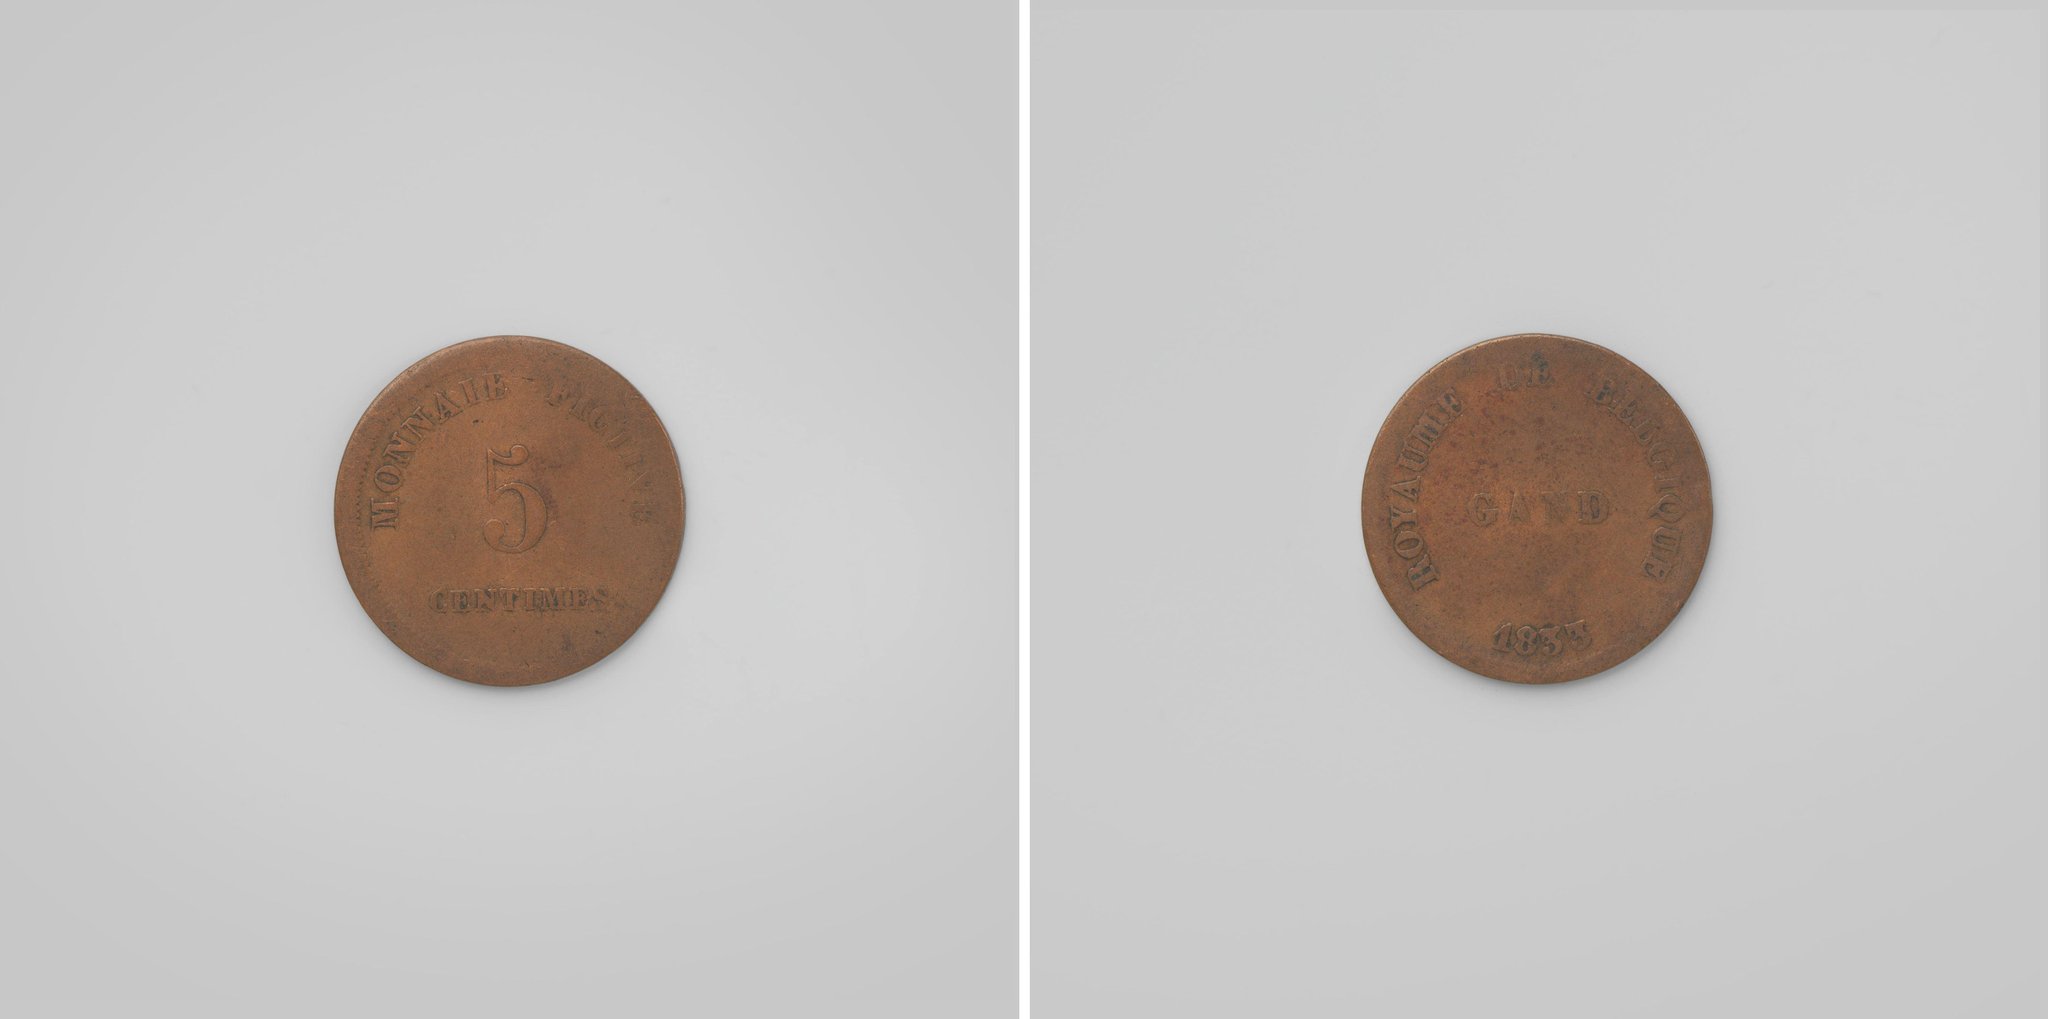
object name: coin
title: 5 centimes uit Gent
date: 1833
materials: copper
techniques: striking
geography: namur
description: Koperen munt. Huismunt. Voorzijde: waarde-aanduiding 5. Keerzijde: versiering, waaronder eenregelig opschrift. Omschrift.